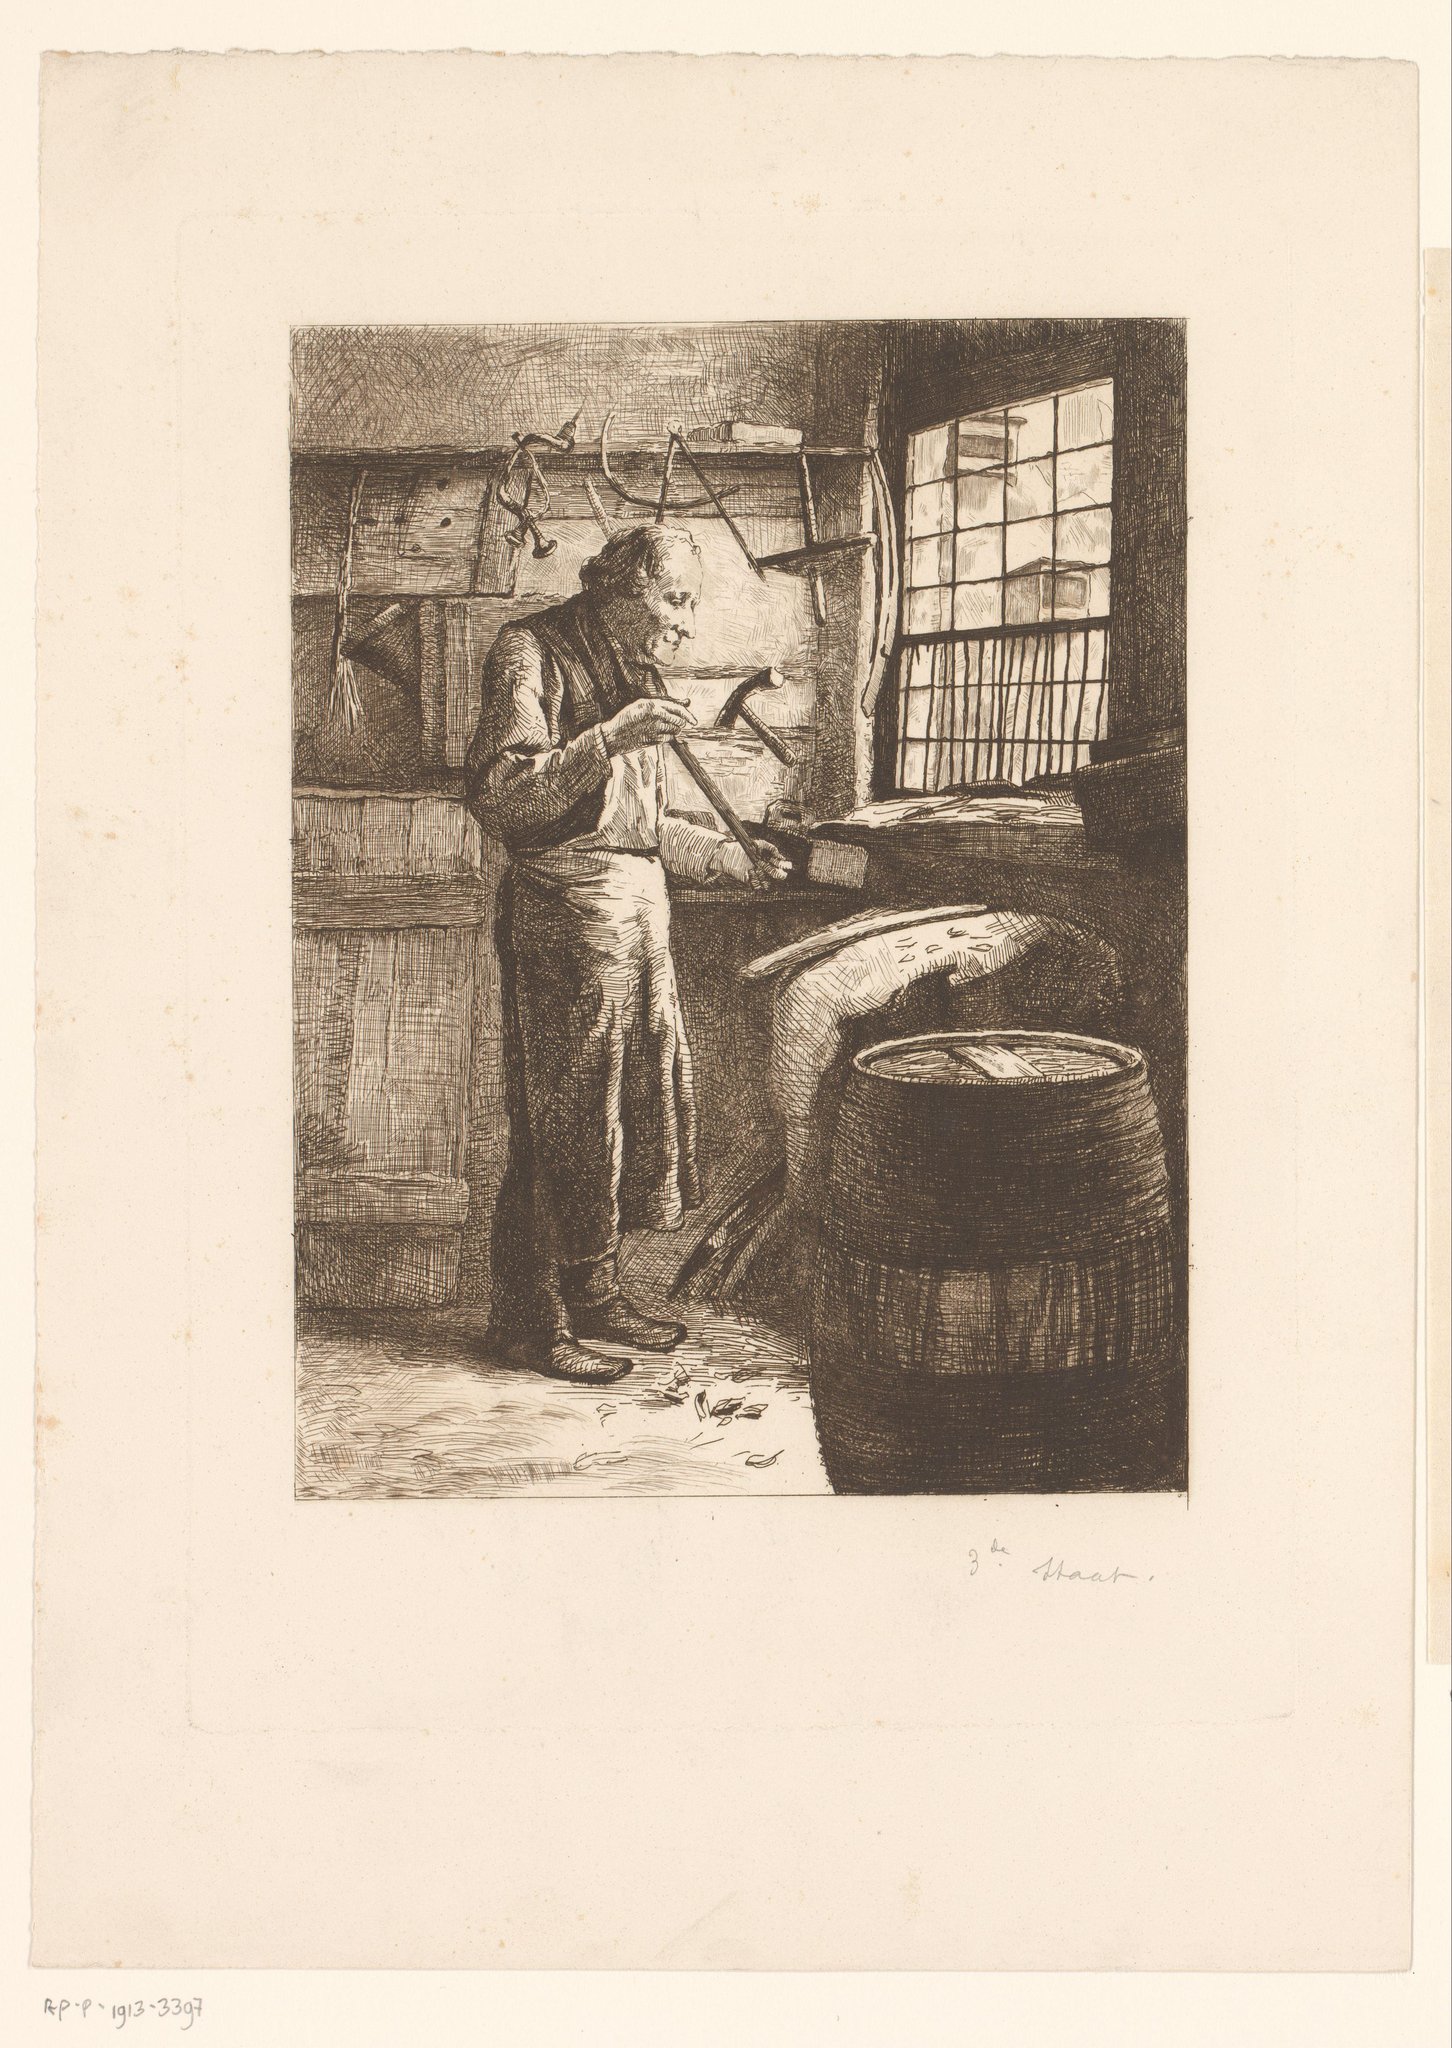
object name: print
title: Kuiper aan het werk in zijn werkplaats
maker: piet verhaert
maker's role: print maker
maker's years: 1852-1908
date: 1883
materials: paper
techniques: etching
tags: handicrafts, craftsman at work, wooden container: barrel, cask, bucket, workshop-interior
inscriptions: collector's mark: Lugt 2228